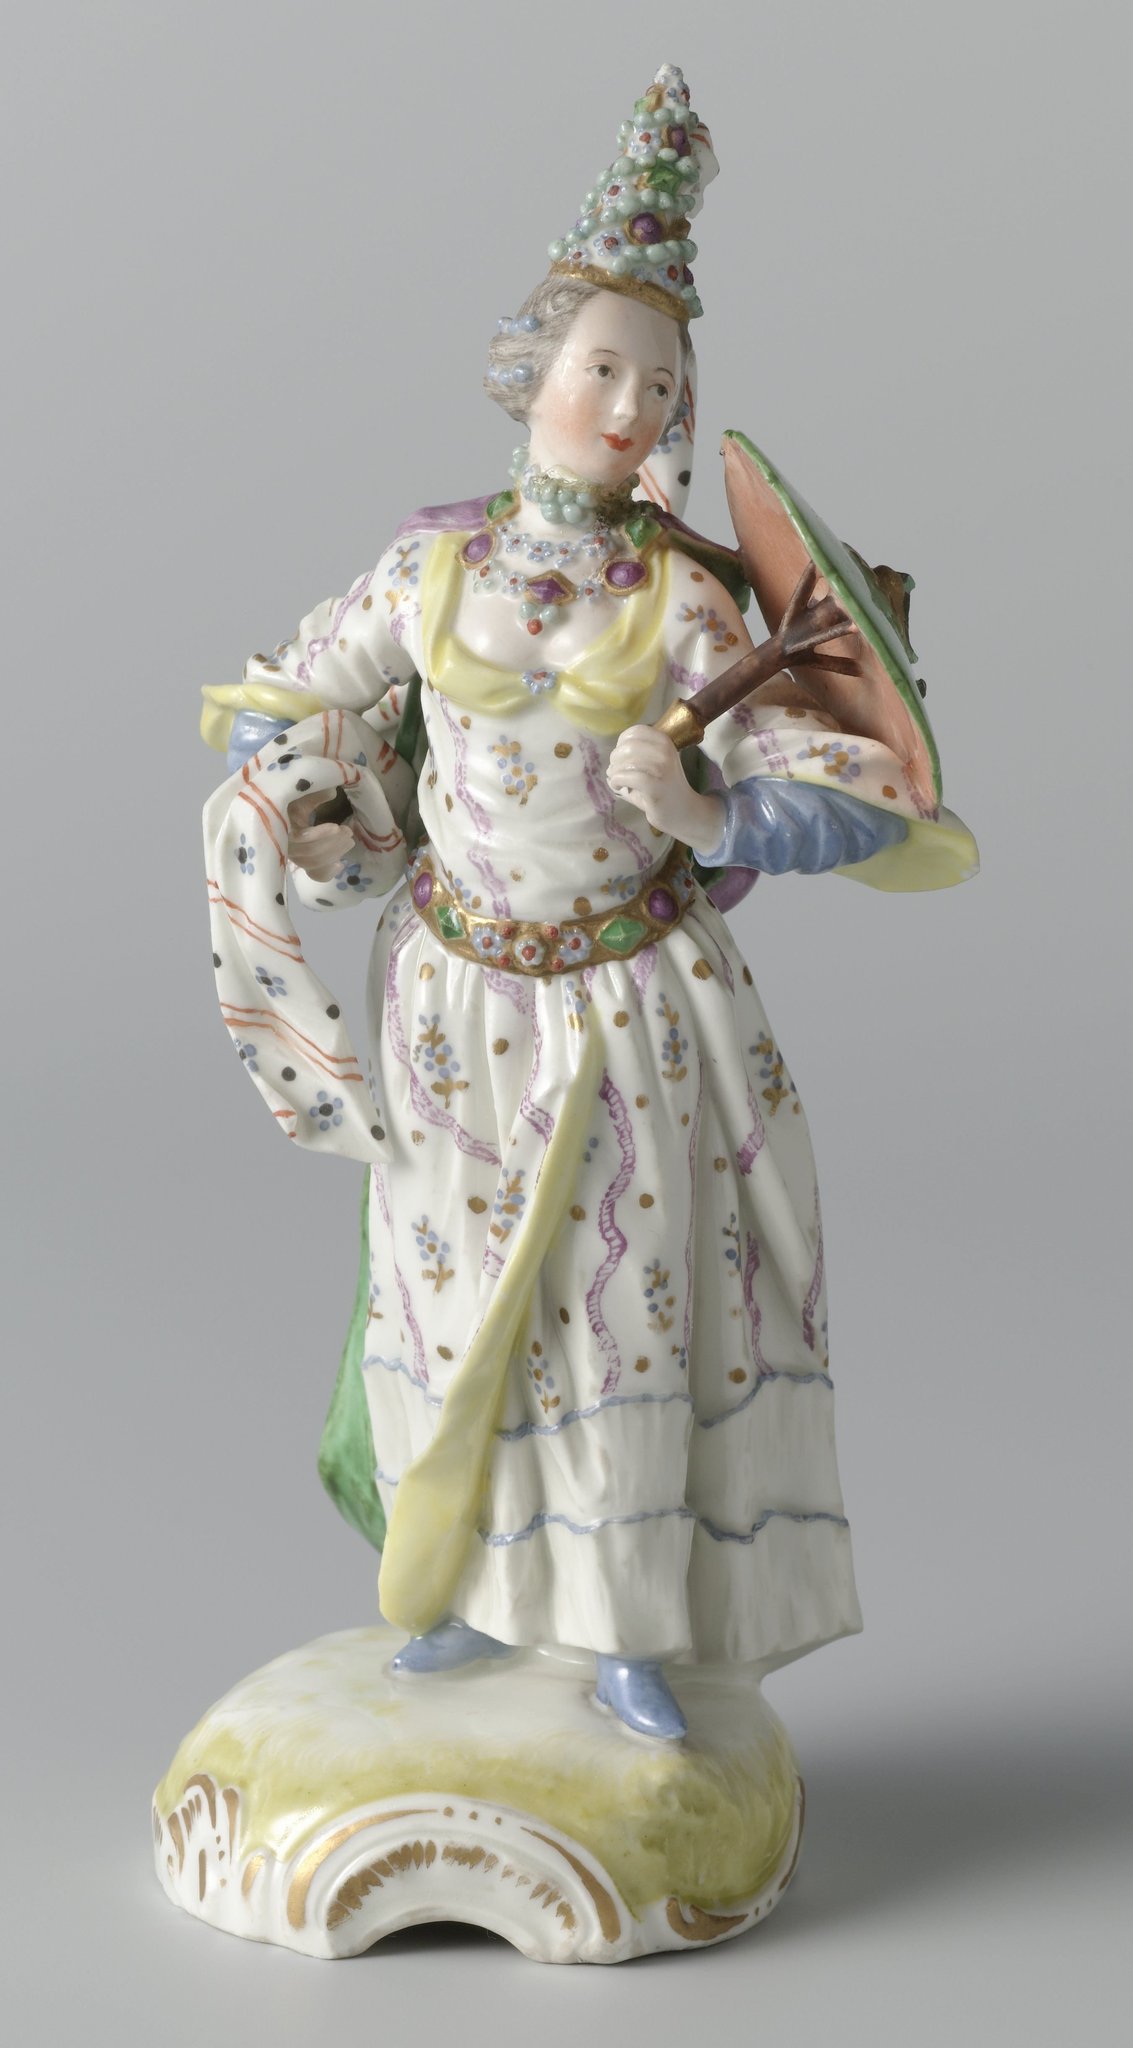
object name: figure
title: Figure of a sultana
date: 1768-1775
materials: glaze, gold, paint, porcelain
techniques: firing, forming, gilding, vitrification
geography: fulda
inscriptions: mark: ‘kruis’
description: A sultan and sultana. Porcelain. Fulda, c. 1768 - 1775.